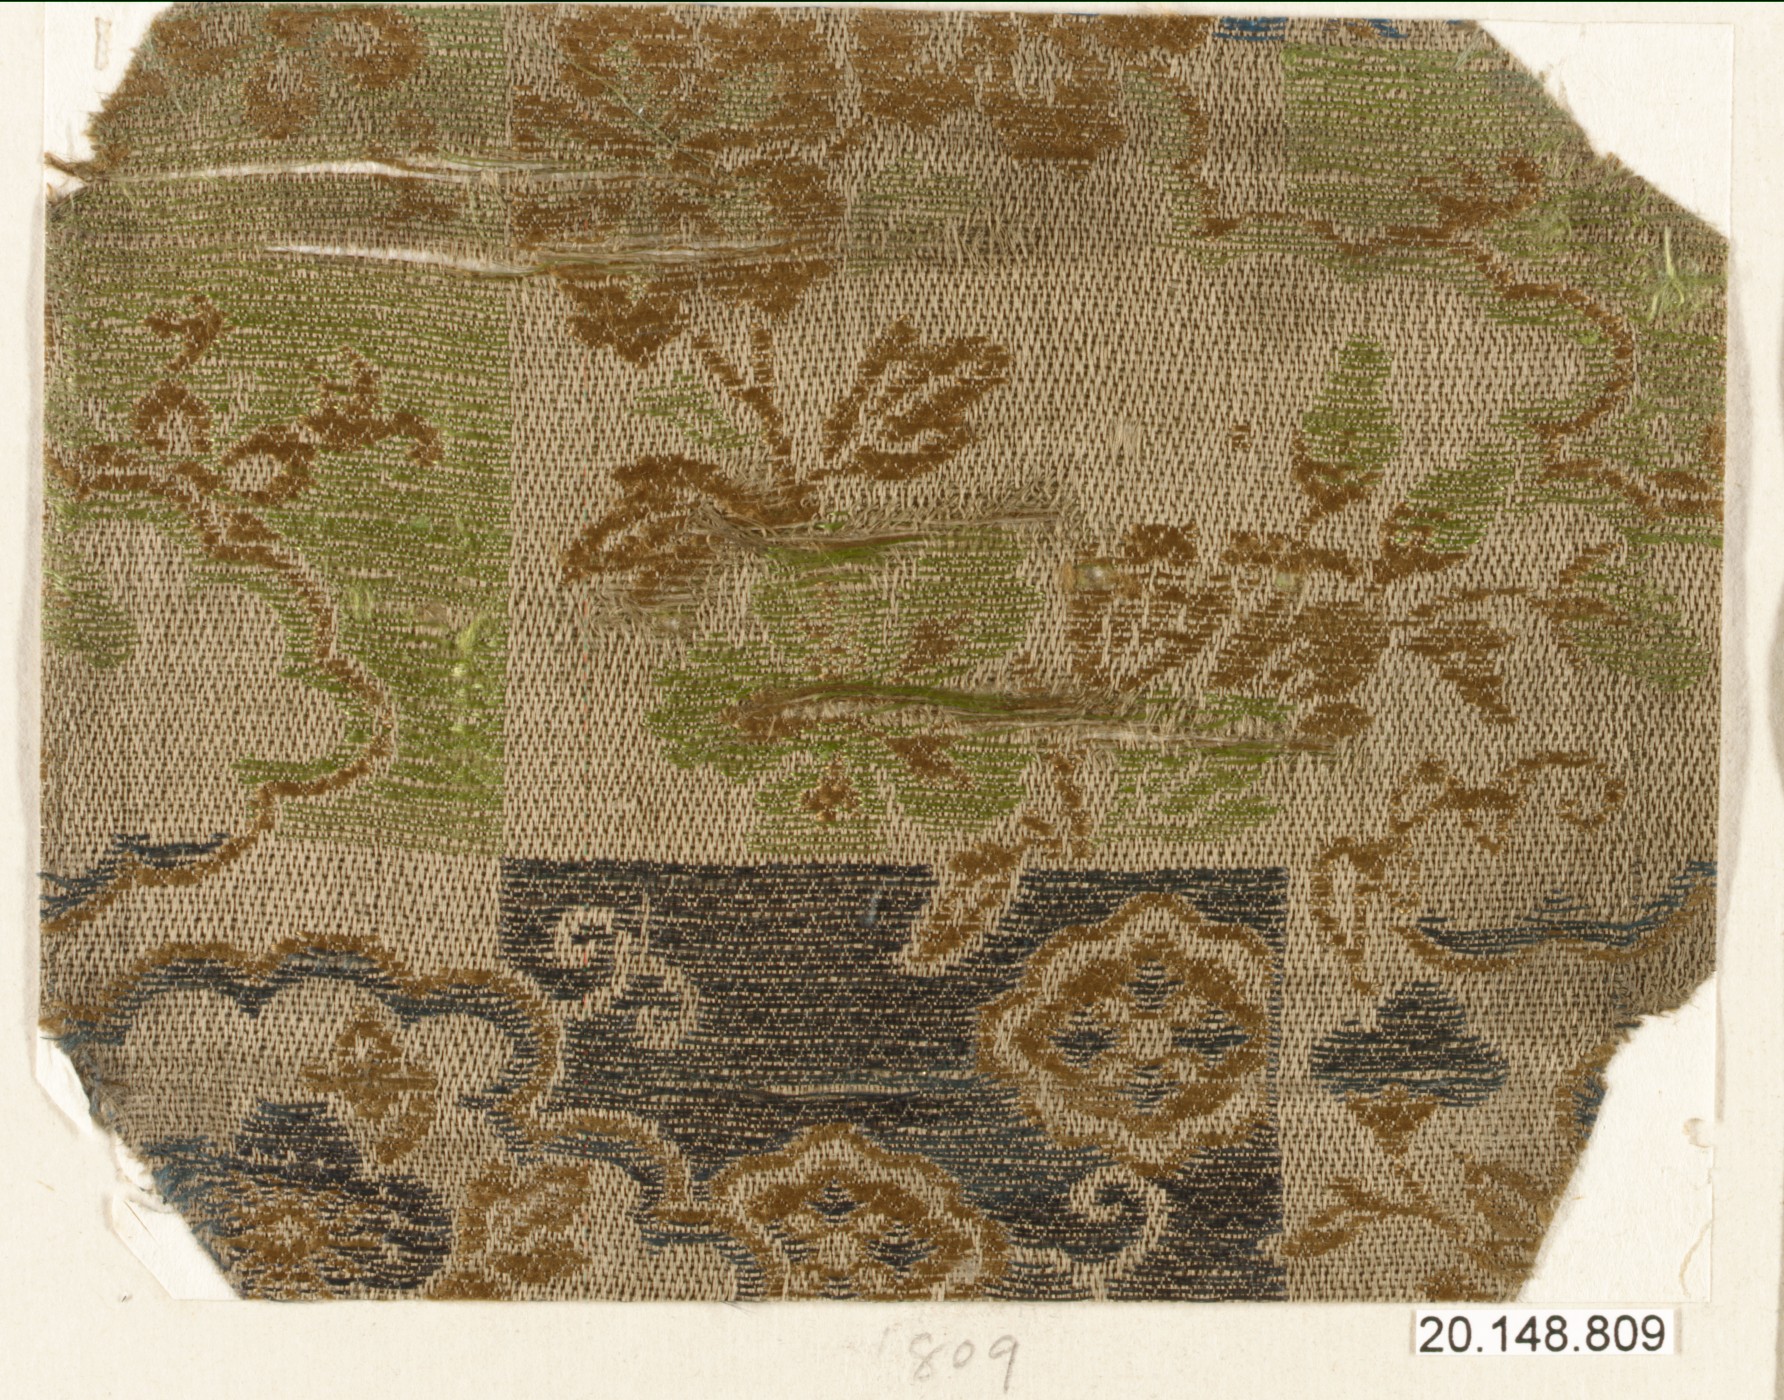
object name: piece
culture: japanese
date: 1701-1800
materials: silk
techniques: compound weave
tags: flowers,leaves